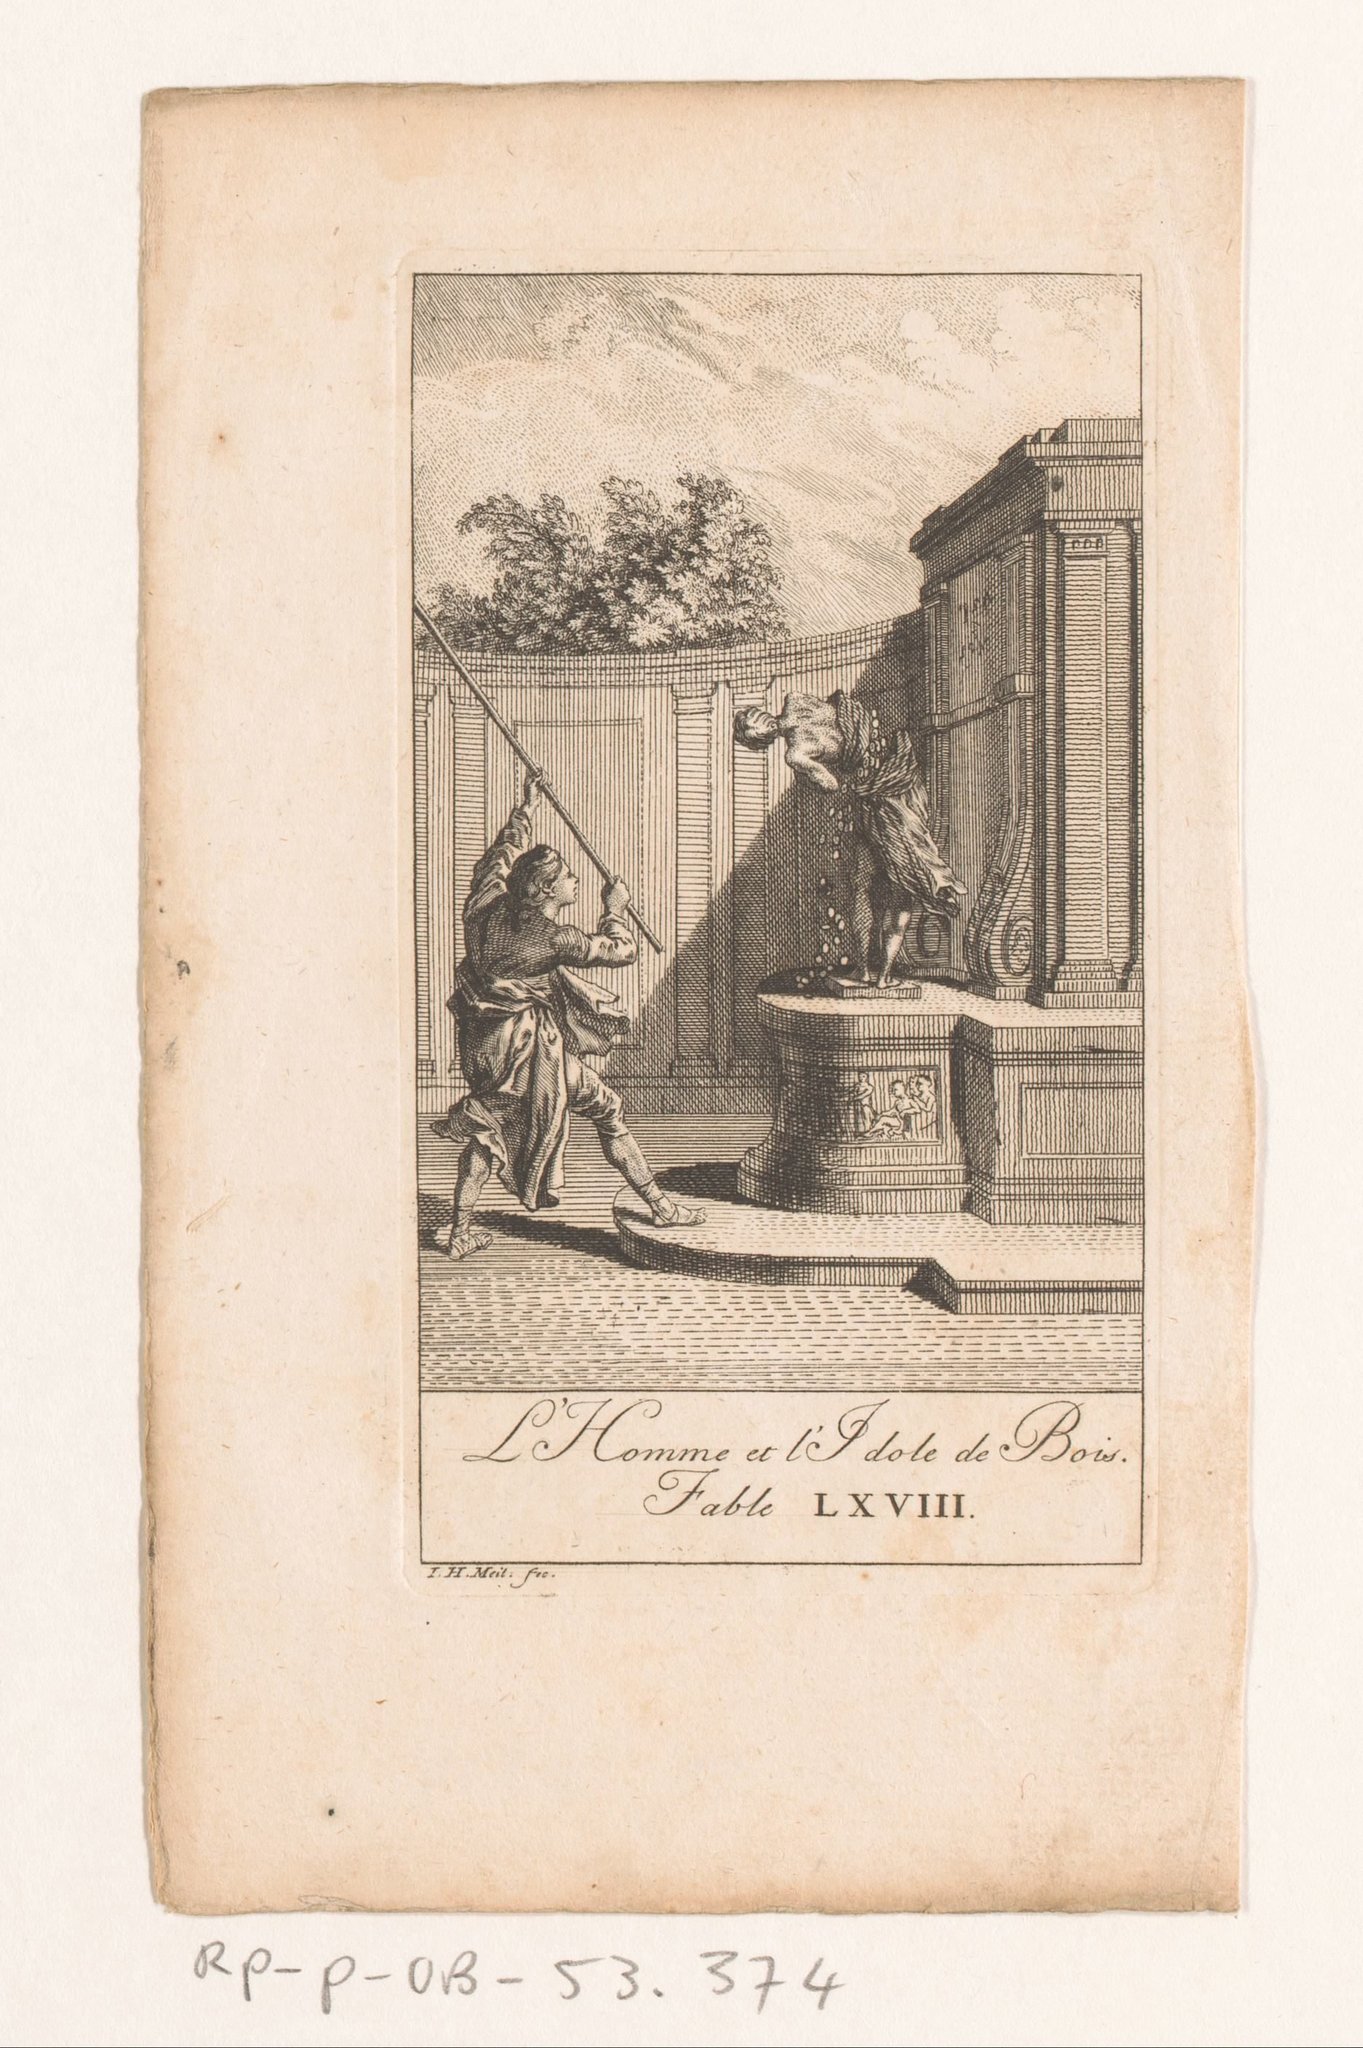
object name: book illustration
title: Fabels van J. de la Fontaine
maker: johann heinrich meil (der ältere)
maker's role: print maker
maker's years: 1730-1820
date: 1758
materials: paper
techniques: etching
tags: fables of lafontaine : use 85(...)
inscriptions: collector's mark: Lugt 2228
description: Illustratie uit: Fontaine, J. de la. Fables choisies, mises en vers. Dl. 2. Dresden & Leipzig: George Conrad Walther, 1758.